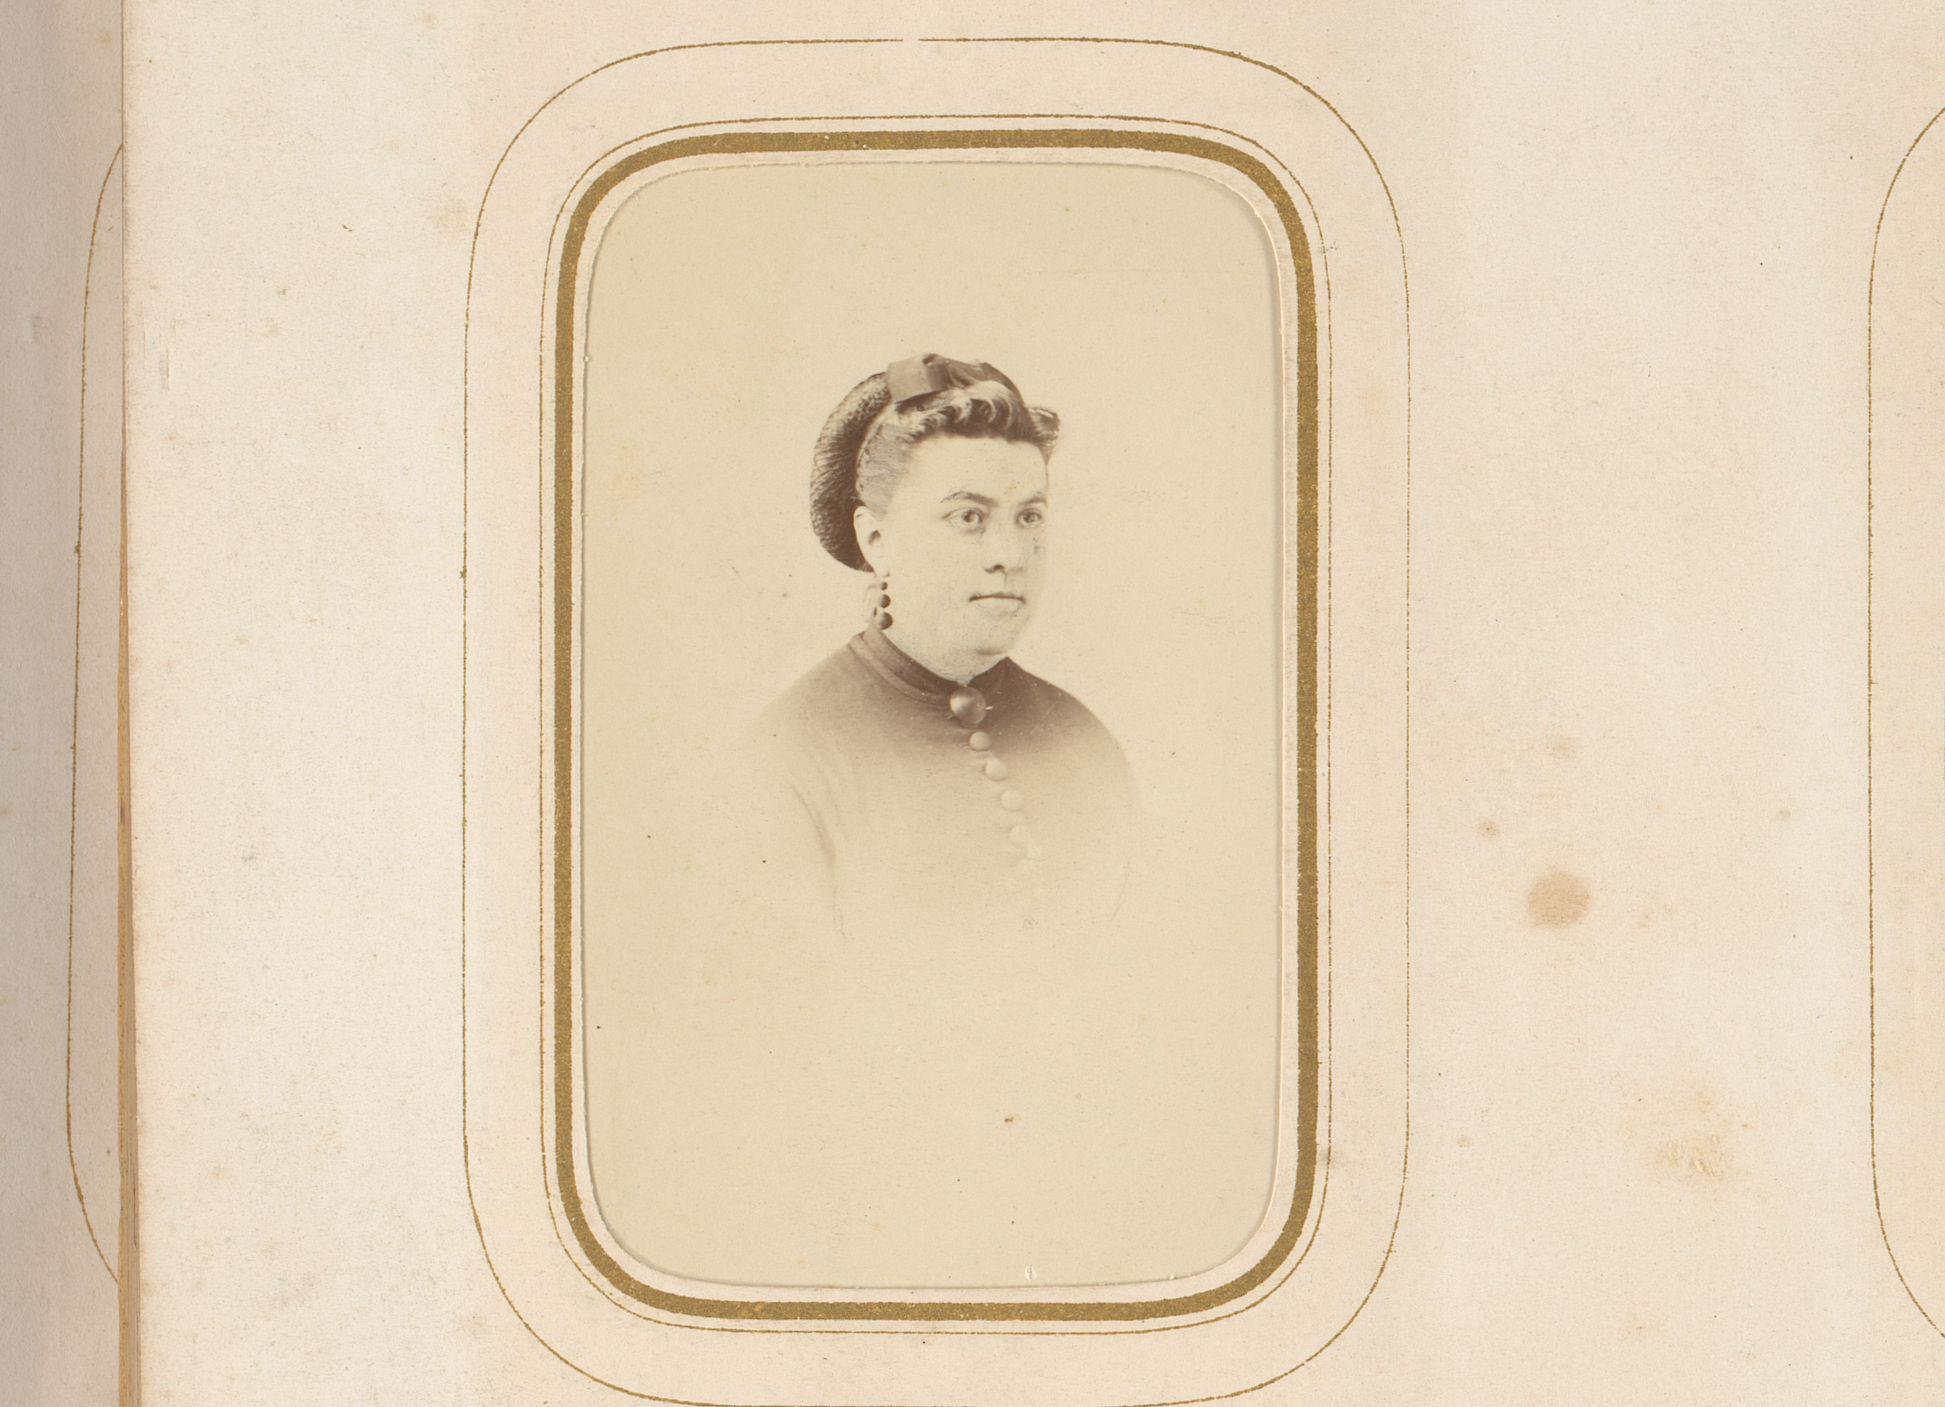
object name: carte de visite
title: Portret van een vrouw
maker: henri langerock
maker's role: painter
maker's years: 1830-1915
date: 1867-1890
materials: cardboard, photographic support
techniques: albumen print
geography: paris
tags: historical persons - bb - woman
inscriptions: inscription: ‘Paris 1867/ Langerock/ Succr de/ Numa Blanc/ Peintre Photographe/ 29, Bould. des Italiens, 29/ Paris’, inscription: ‘Langerock Succr de/ Numa Blanc’